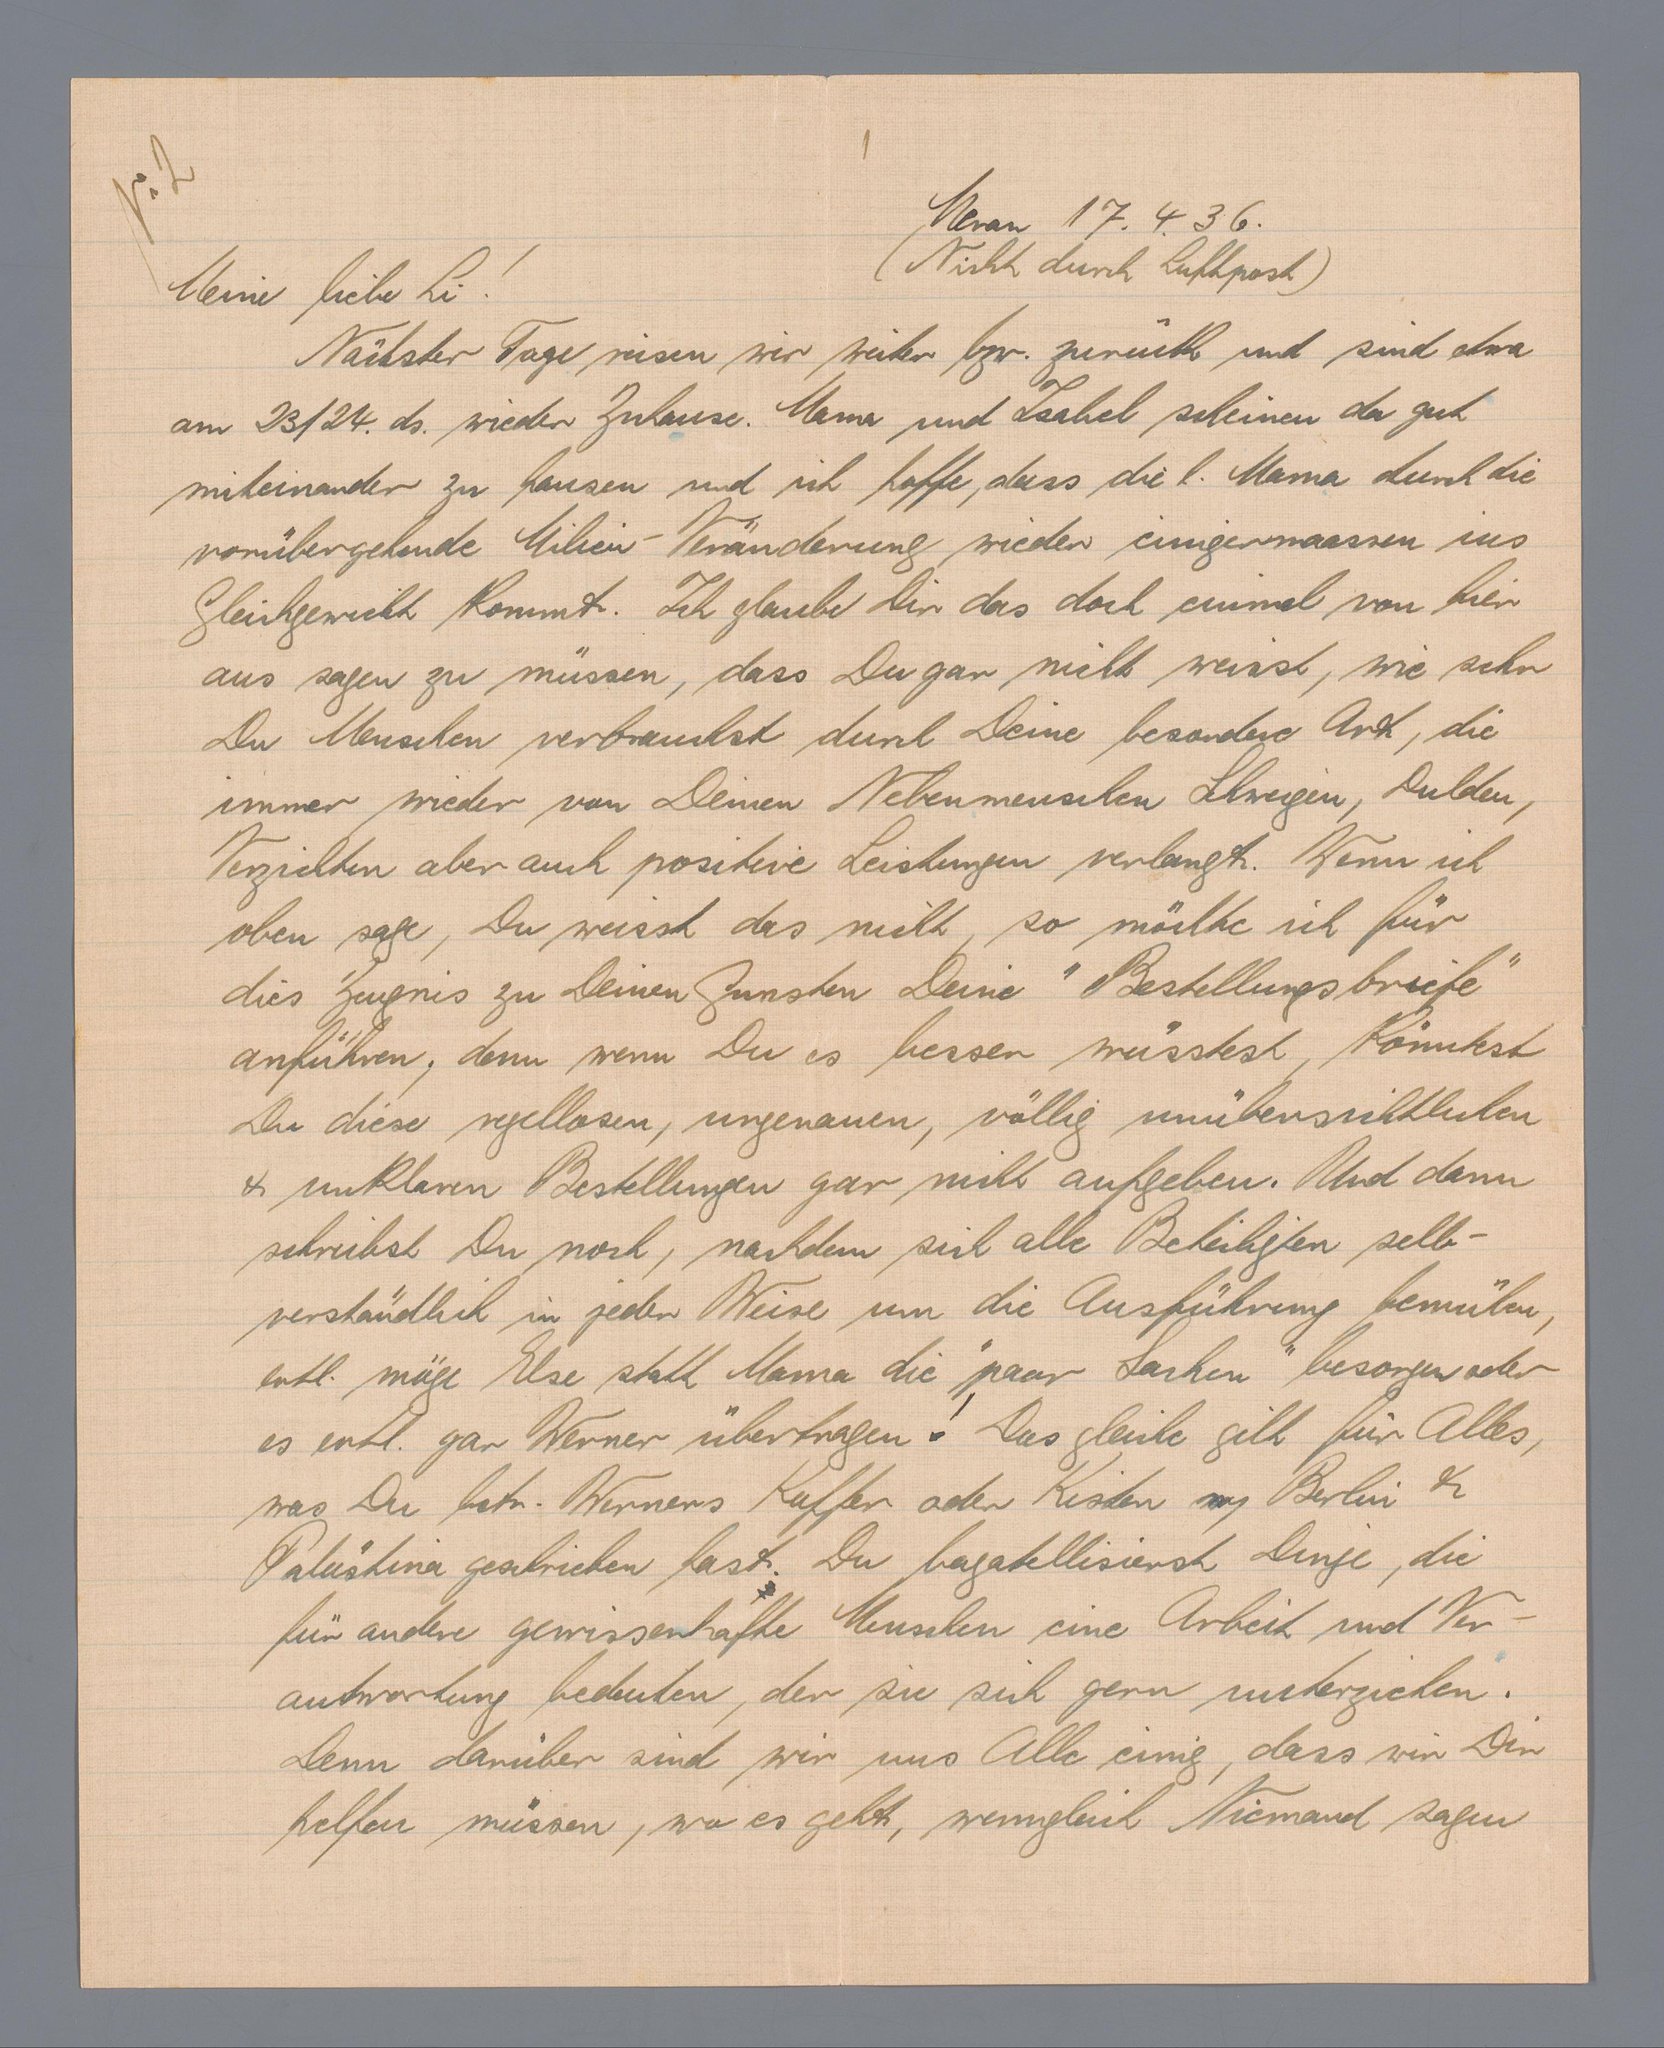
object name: letter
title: Belangrijke brieven met betrekking tot het leven van Isabel Wachenheimer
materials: paper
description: Dit object is onderdeel van de nalatenschap van Isabel Elon-Wachenheimer (1928-2010). Tot haar overlijden behoorde het samen met de andere objecten uit de nalatenschap tot haar privédomein van Isabel Wachenheimer. In die particuliere context zijn deze objecten tezamen en individueel aandenkens - aan de jeugd, ouders en familie van Isabel Wachenheimer vóór en tijdens de Shoah en aan haar leven na de Tweede Wereldoorlog. Isabel Wachenheimer, die van juni 1943 tot mei 1945 gevangen zat in Kamp Westerbork, Theresienstadt, Auschwitz, Lenzing a/d Oberdonau (een buitenkamp van Mauthausen), overleefde de Shoah. Haar ouders – Eugène Wachenheimer en Else Wachenheimer-Moos - werden op 14 oktober 1944 in Auschwitz-Birkenau vermoord.